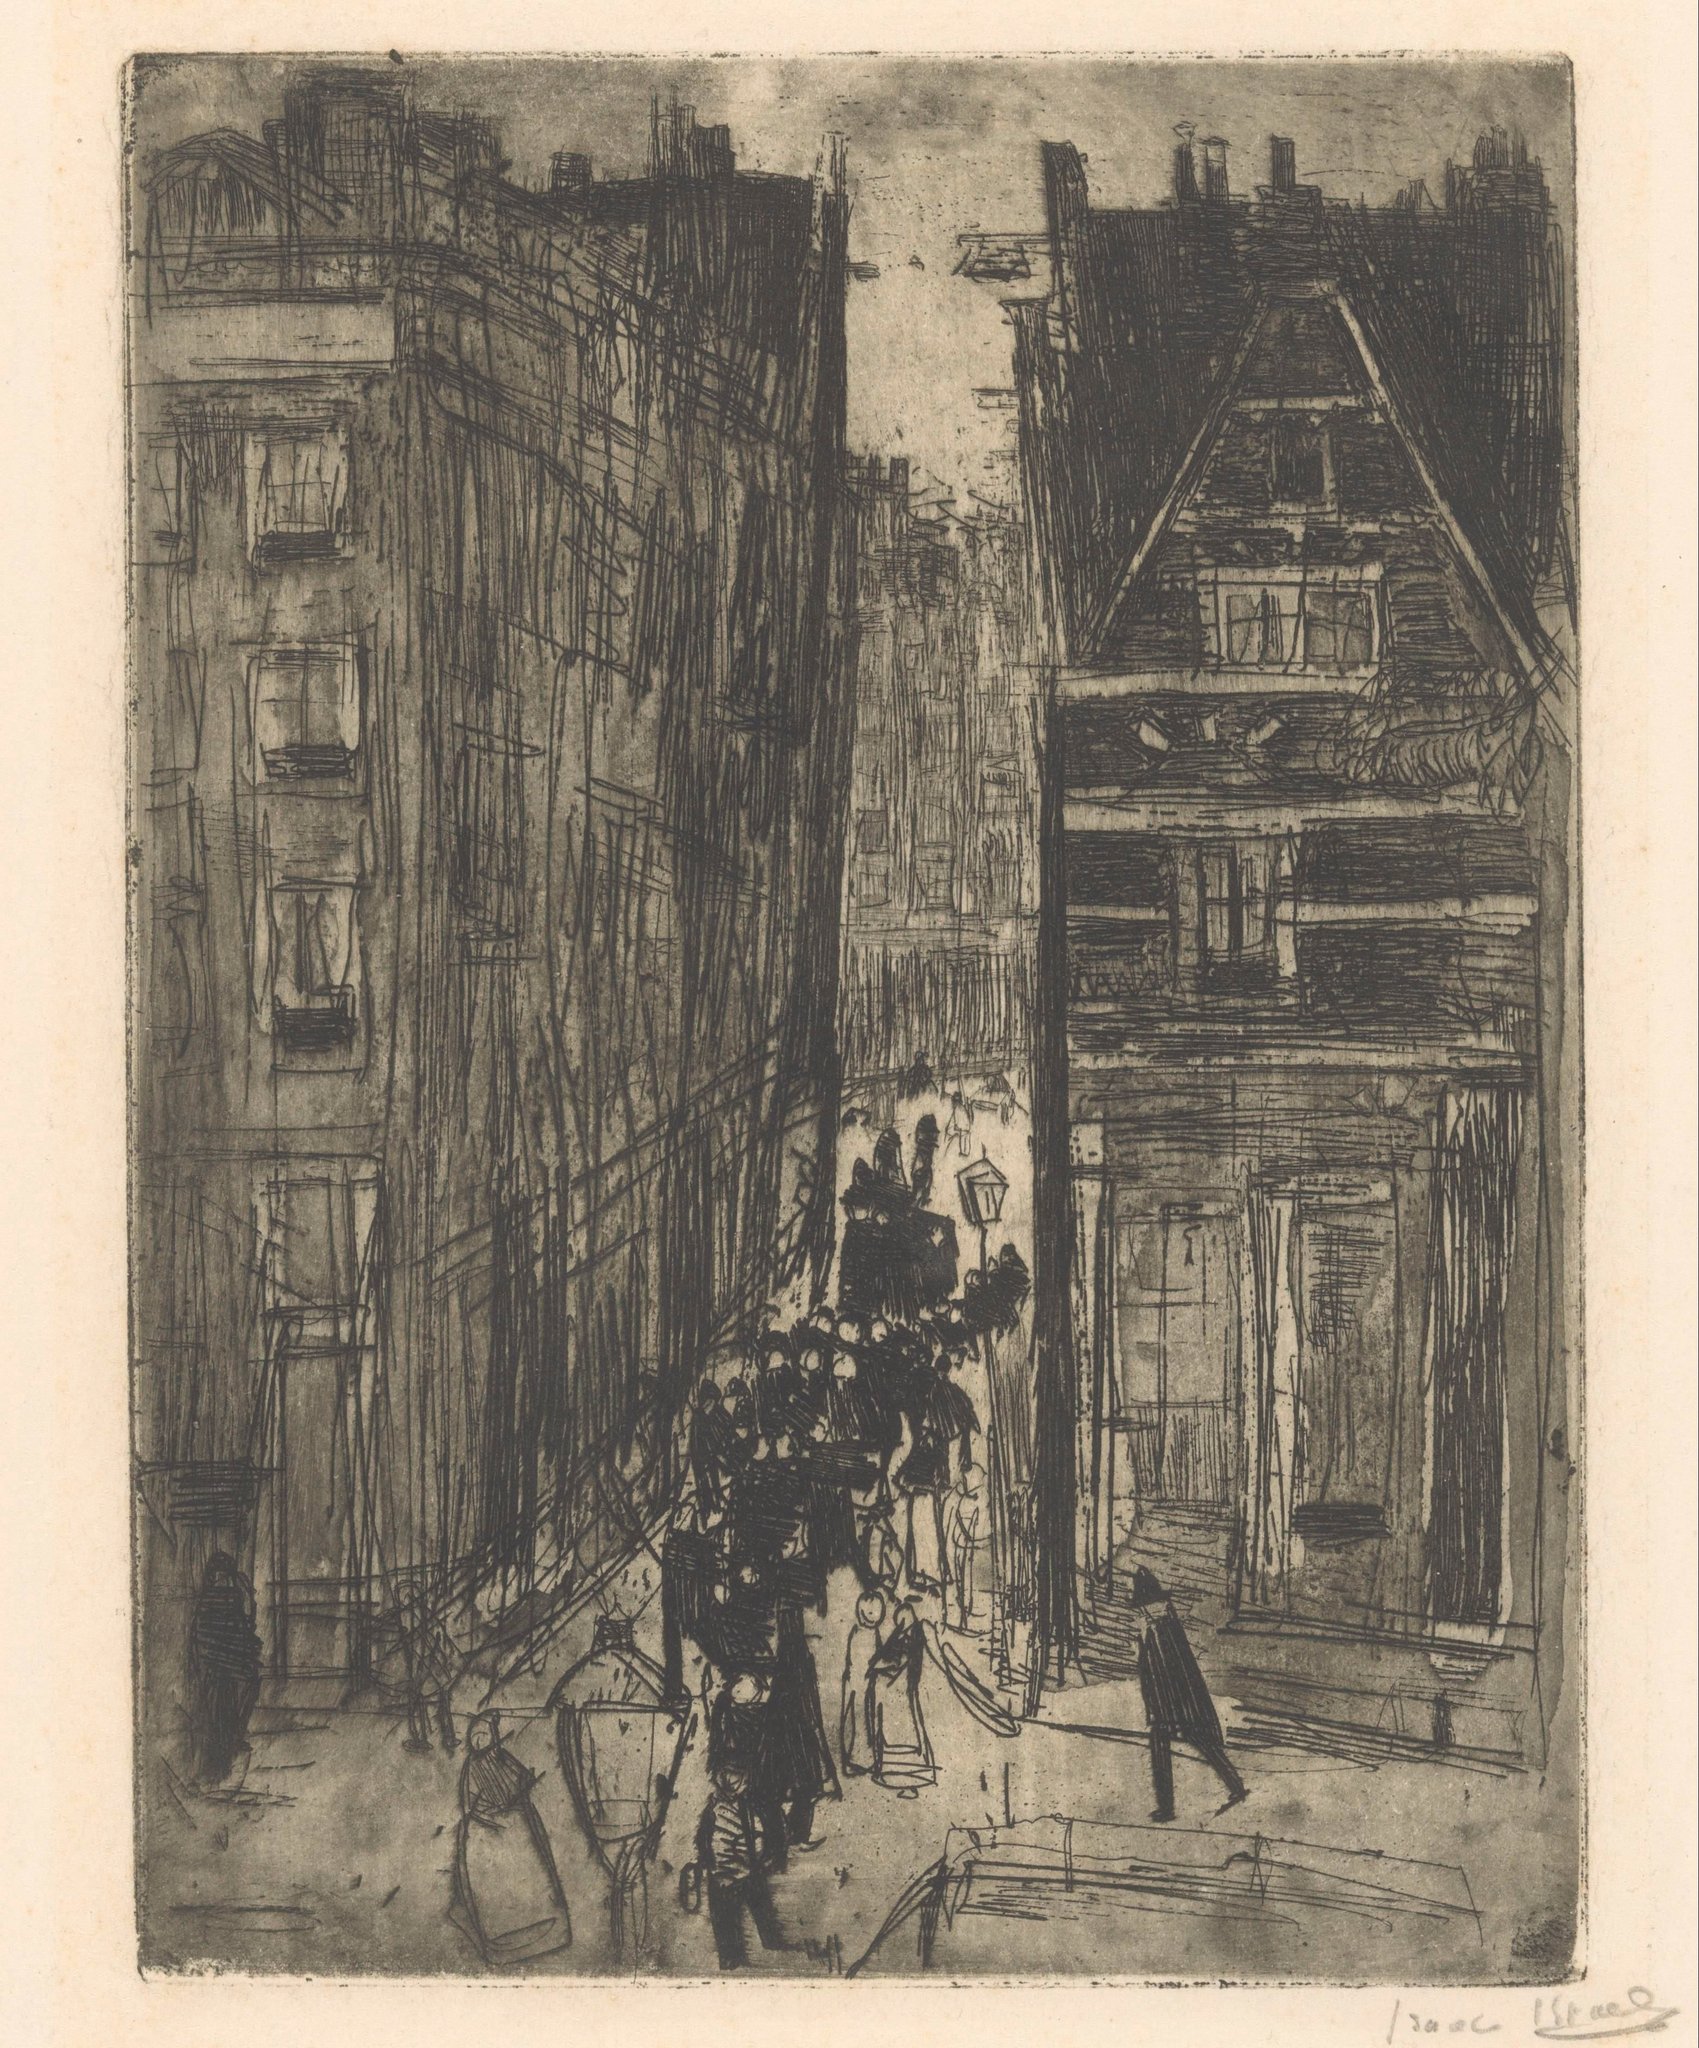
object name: print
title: Halvemaansteeg te Amsterdam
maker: isaac israels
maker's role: draughtsman, painter, print maker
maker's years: 1865-1934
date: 1894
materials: paper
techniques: zinc etching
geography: amsterdam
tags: urban housing, lane, alley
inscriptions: collector's mark: Lugt 2228, number: ‘no 1612’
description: Gasthuismolensteeg in Amsterdam, gezien vanuit Herengracht 232. Spiegelbeeldig.